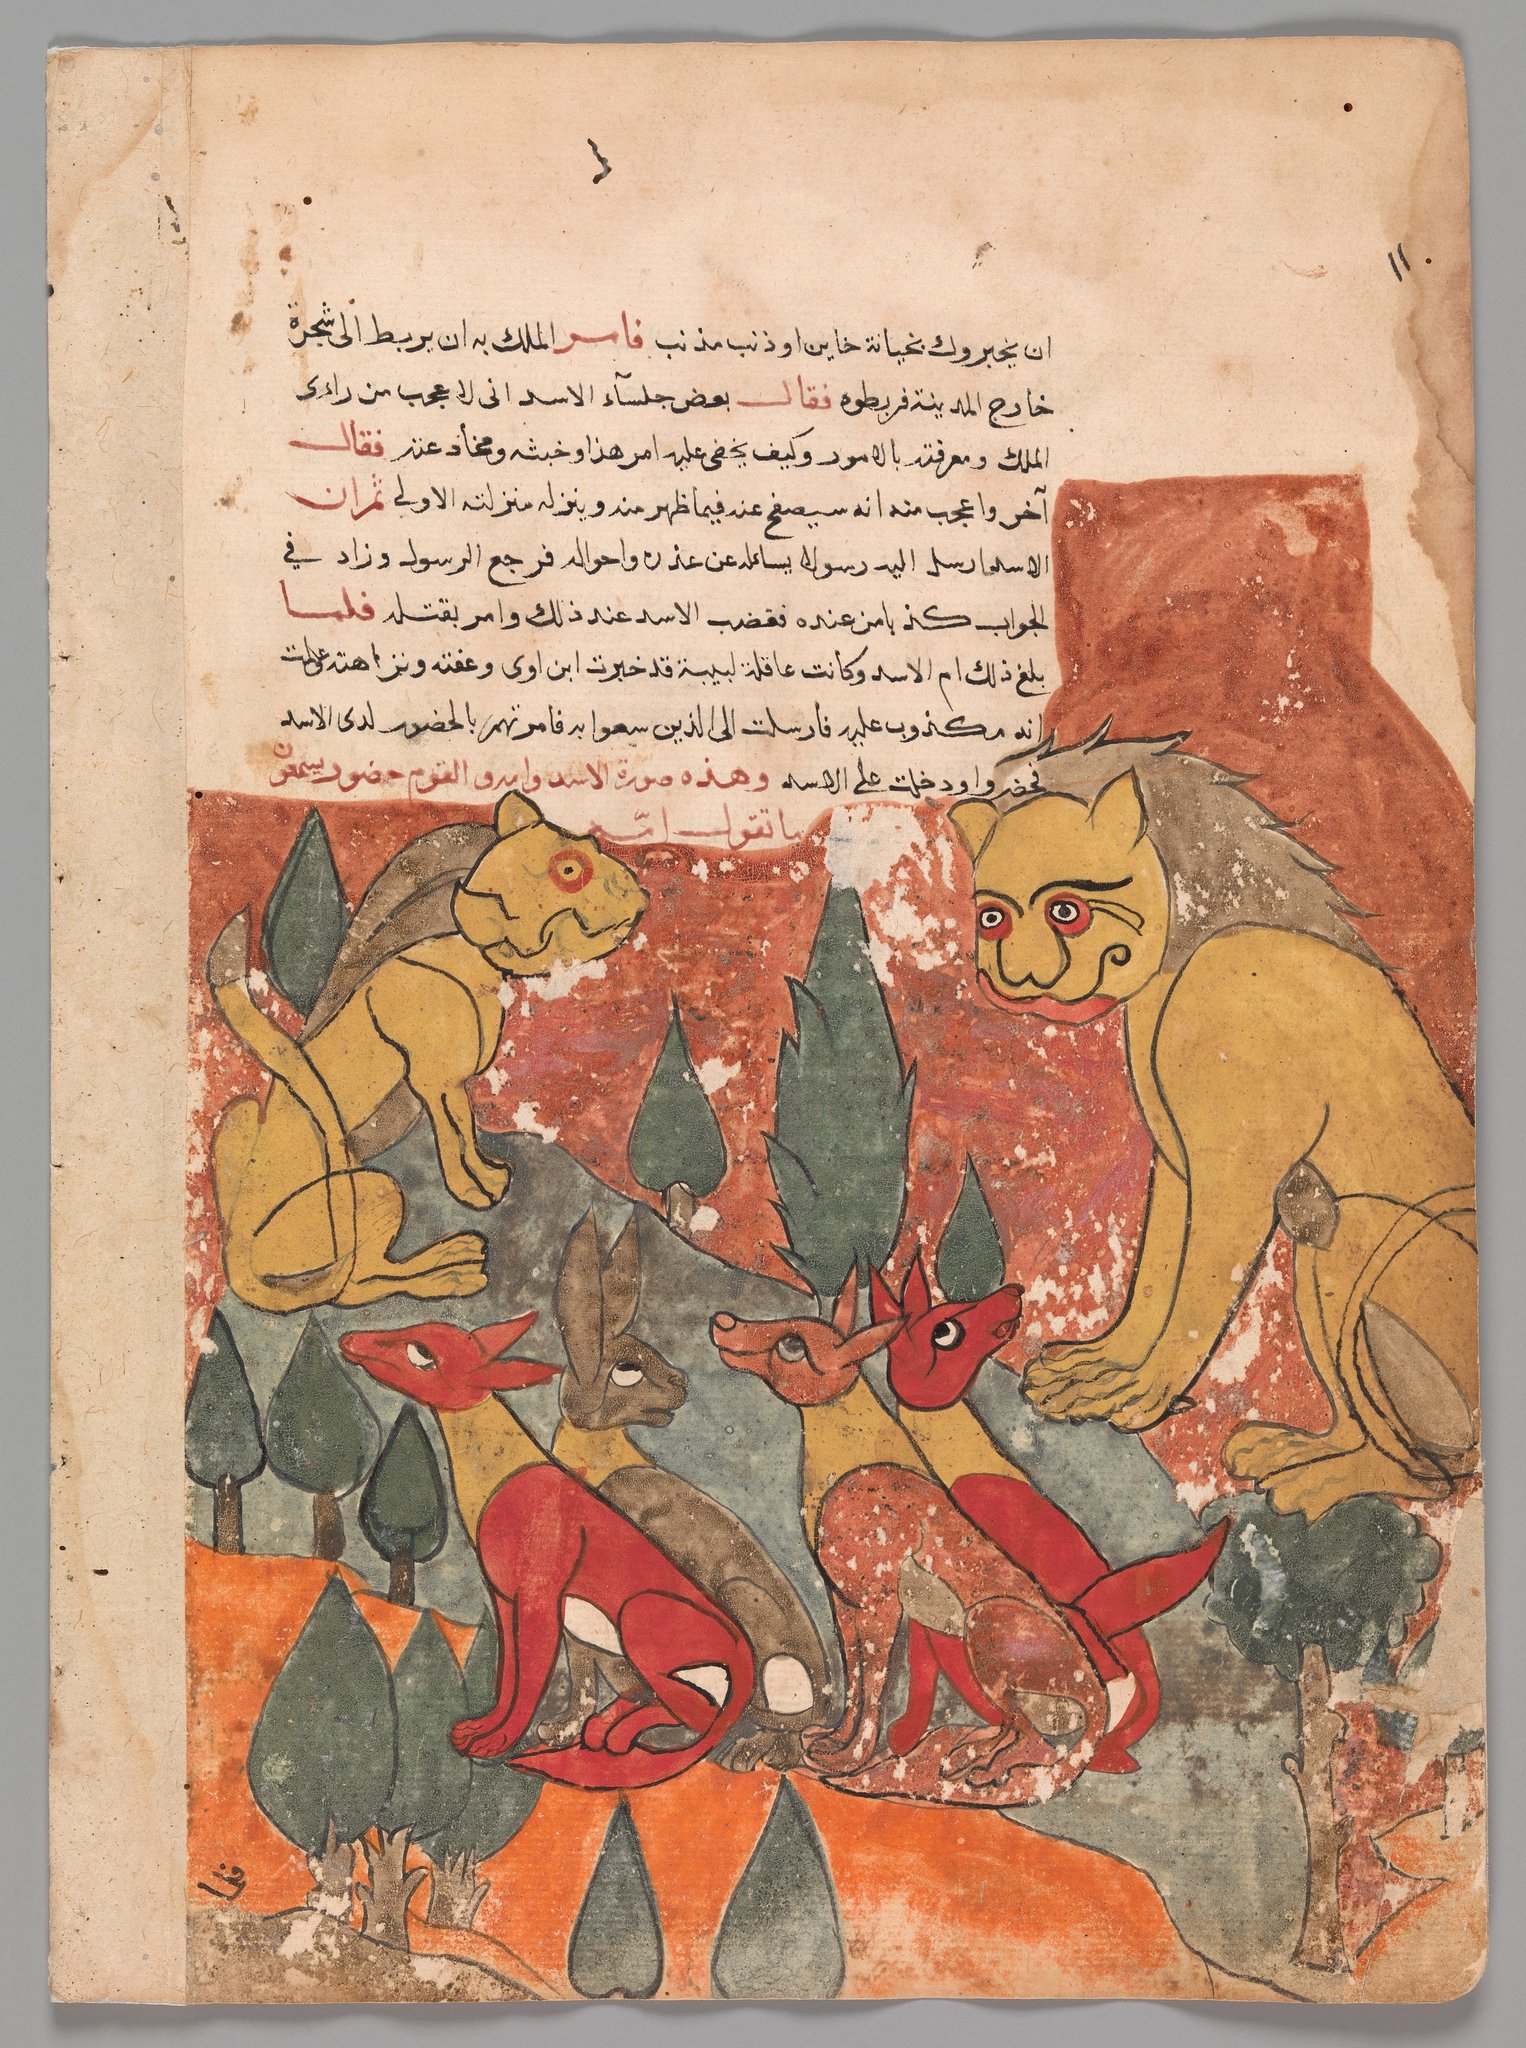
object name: folio from an illustrated manuscript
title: "The Lioness Advises her Son", Folio from a Kalila wa Dimna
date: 1526-1550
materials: ink, paper, watercolor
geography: india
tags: animals,lions